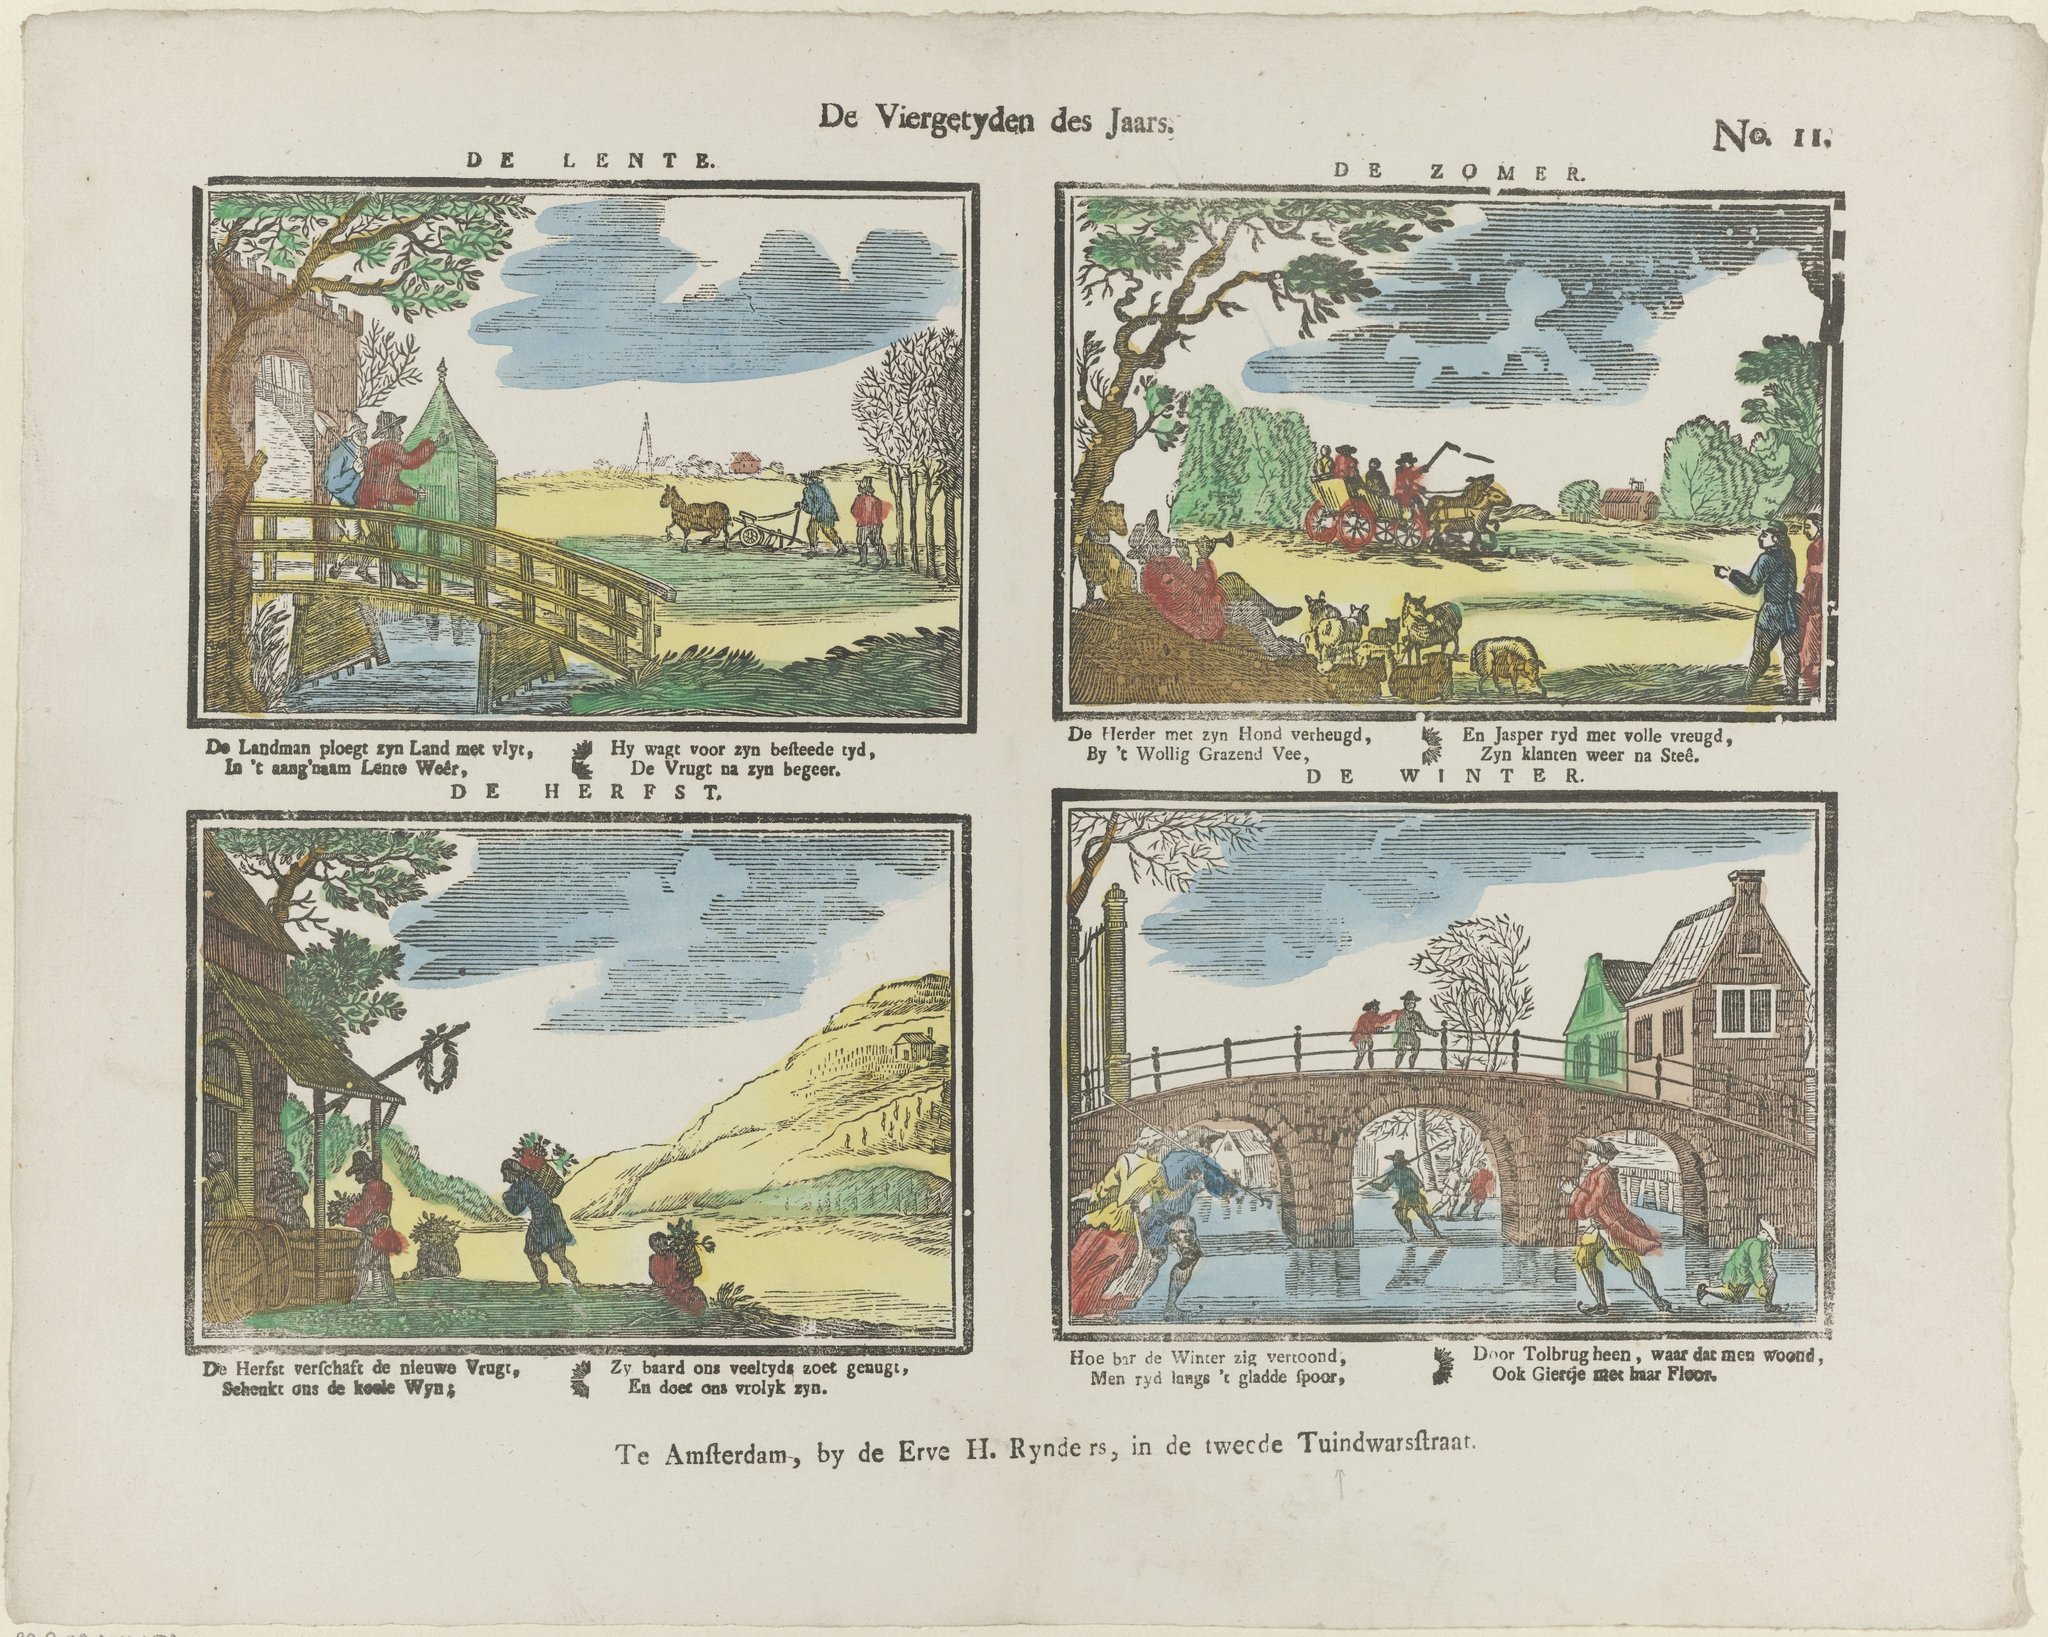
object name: popular print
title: De viergetyden des jaars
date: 1831-1854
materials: paper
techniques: colour, letterpress printing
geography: amsterdam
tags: the four seasons of the year ~ human activities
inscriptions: collector's mark: Lugt 2760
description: Blad met 4 voorstellingen van de vier jaargetijden en bijbehorende activiteiten. Onder elke afbeelding een vierregelig vers in twee kolommen. Genummerd rechtsboven: No. 11.